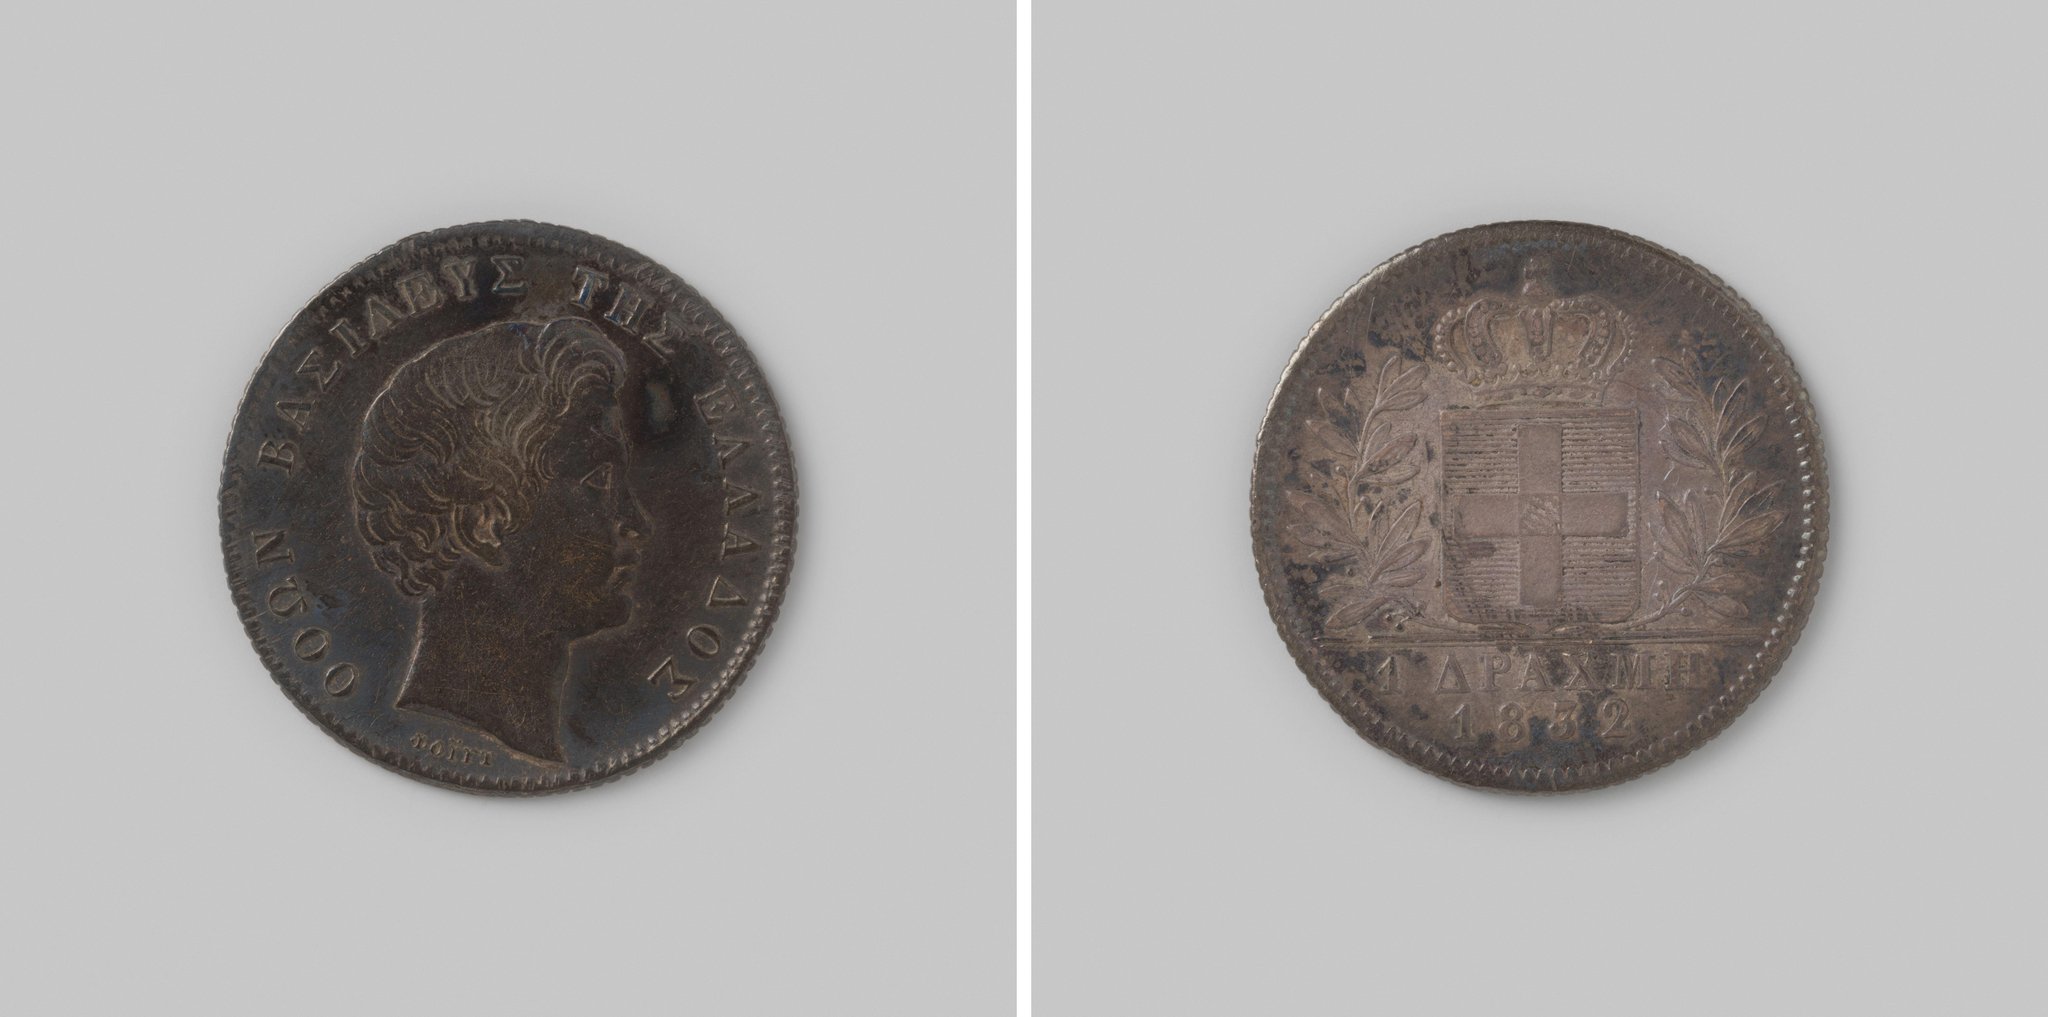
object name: coin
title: Drachme uit Griekenland van koning Otto I, 1832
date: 1832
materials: silver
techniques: striking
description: Zilveren munt. Voorzijde: hoofd van de koning naar rechts. Keerzijde: tussen twee takken gekroond wapenschild. In afsnede waarde-aanduiding in een regel, waaronder jaartal. Kartelrand.